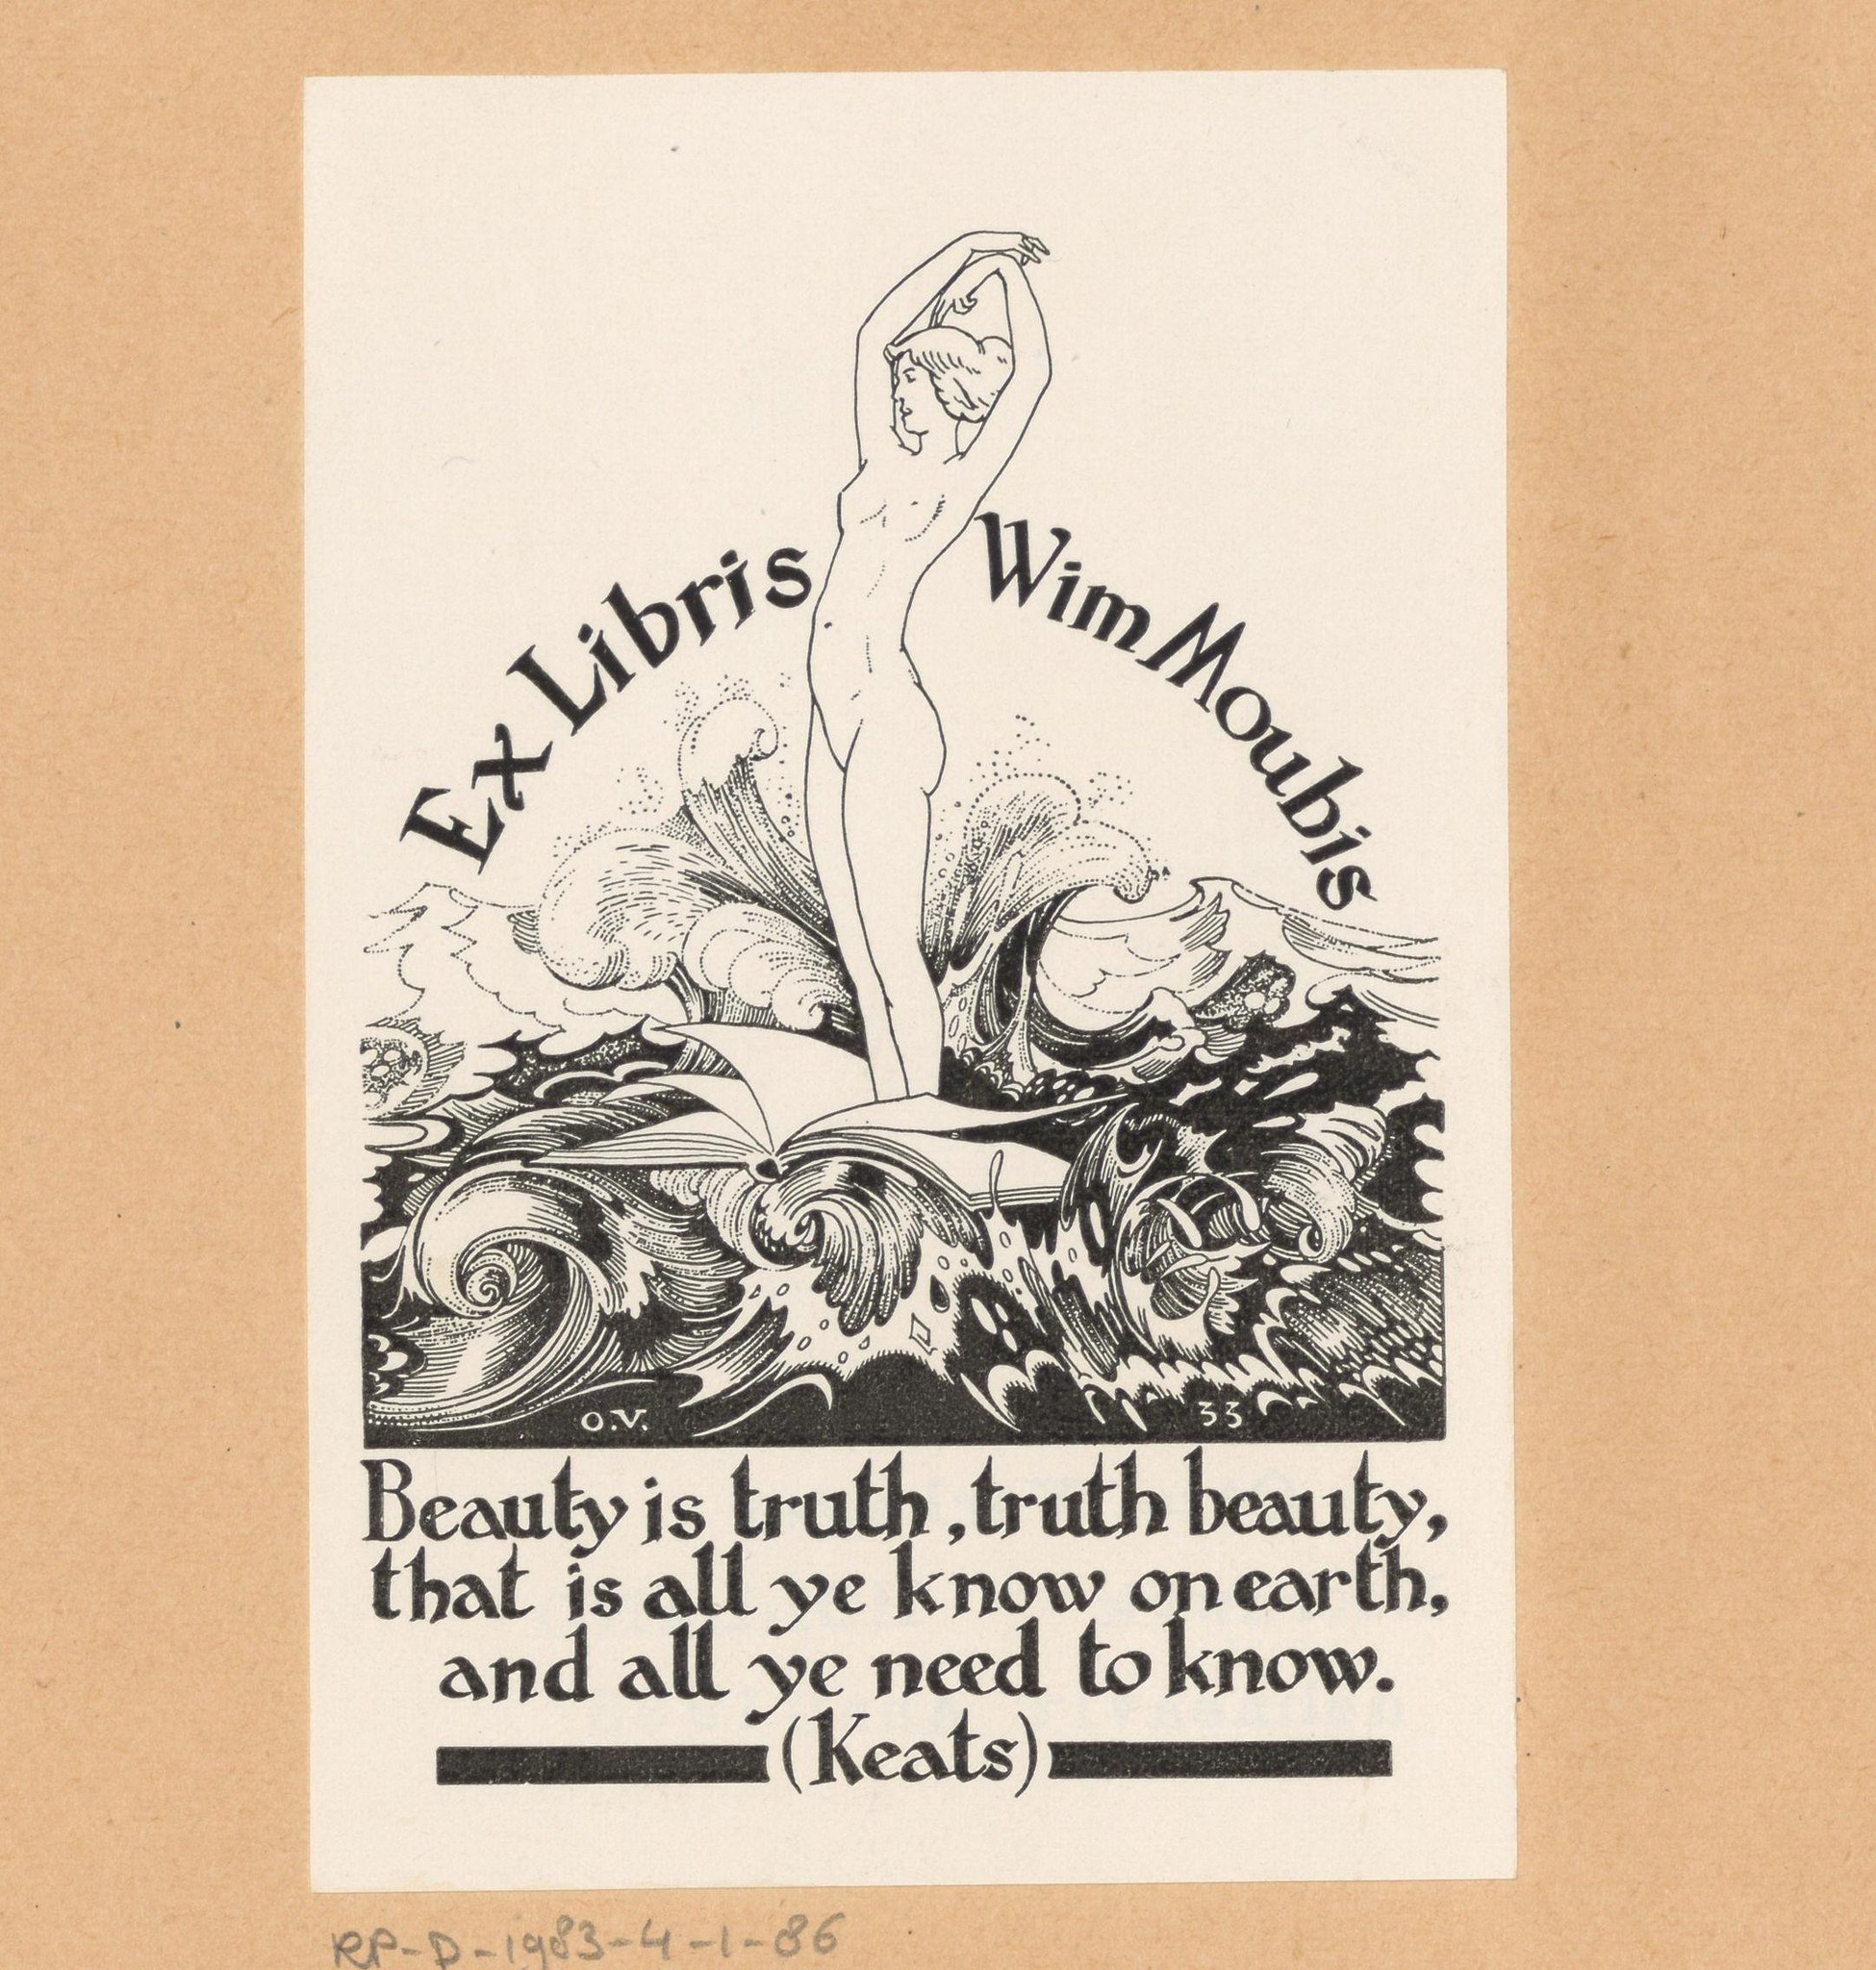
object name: bookplate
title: Ex libris van Wim Moubis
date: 1933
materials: paper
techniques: printing block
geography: netherlands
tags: wave, woman (showing herself) undressed, quasi-nude, book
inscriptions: inscription: ‘Clichédruk - jaar 1933. (...) 1933 Los Angeles.’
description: Verhagen stuurde dit ontwerp in voor de 9th Annual Exhibition of the Bookplate Association International, 1933, Los Angeles.